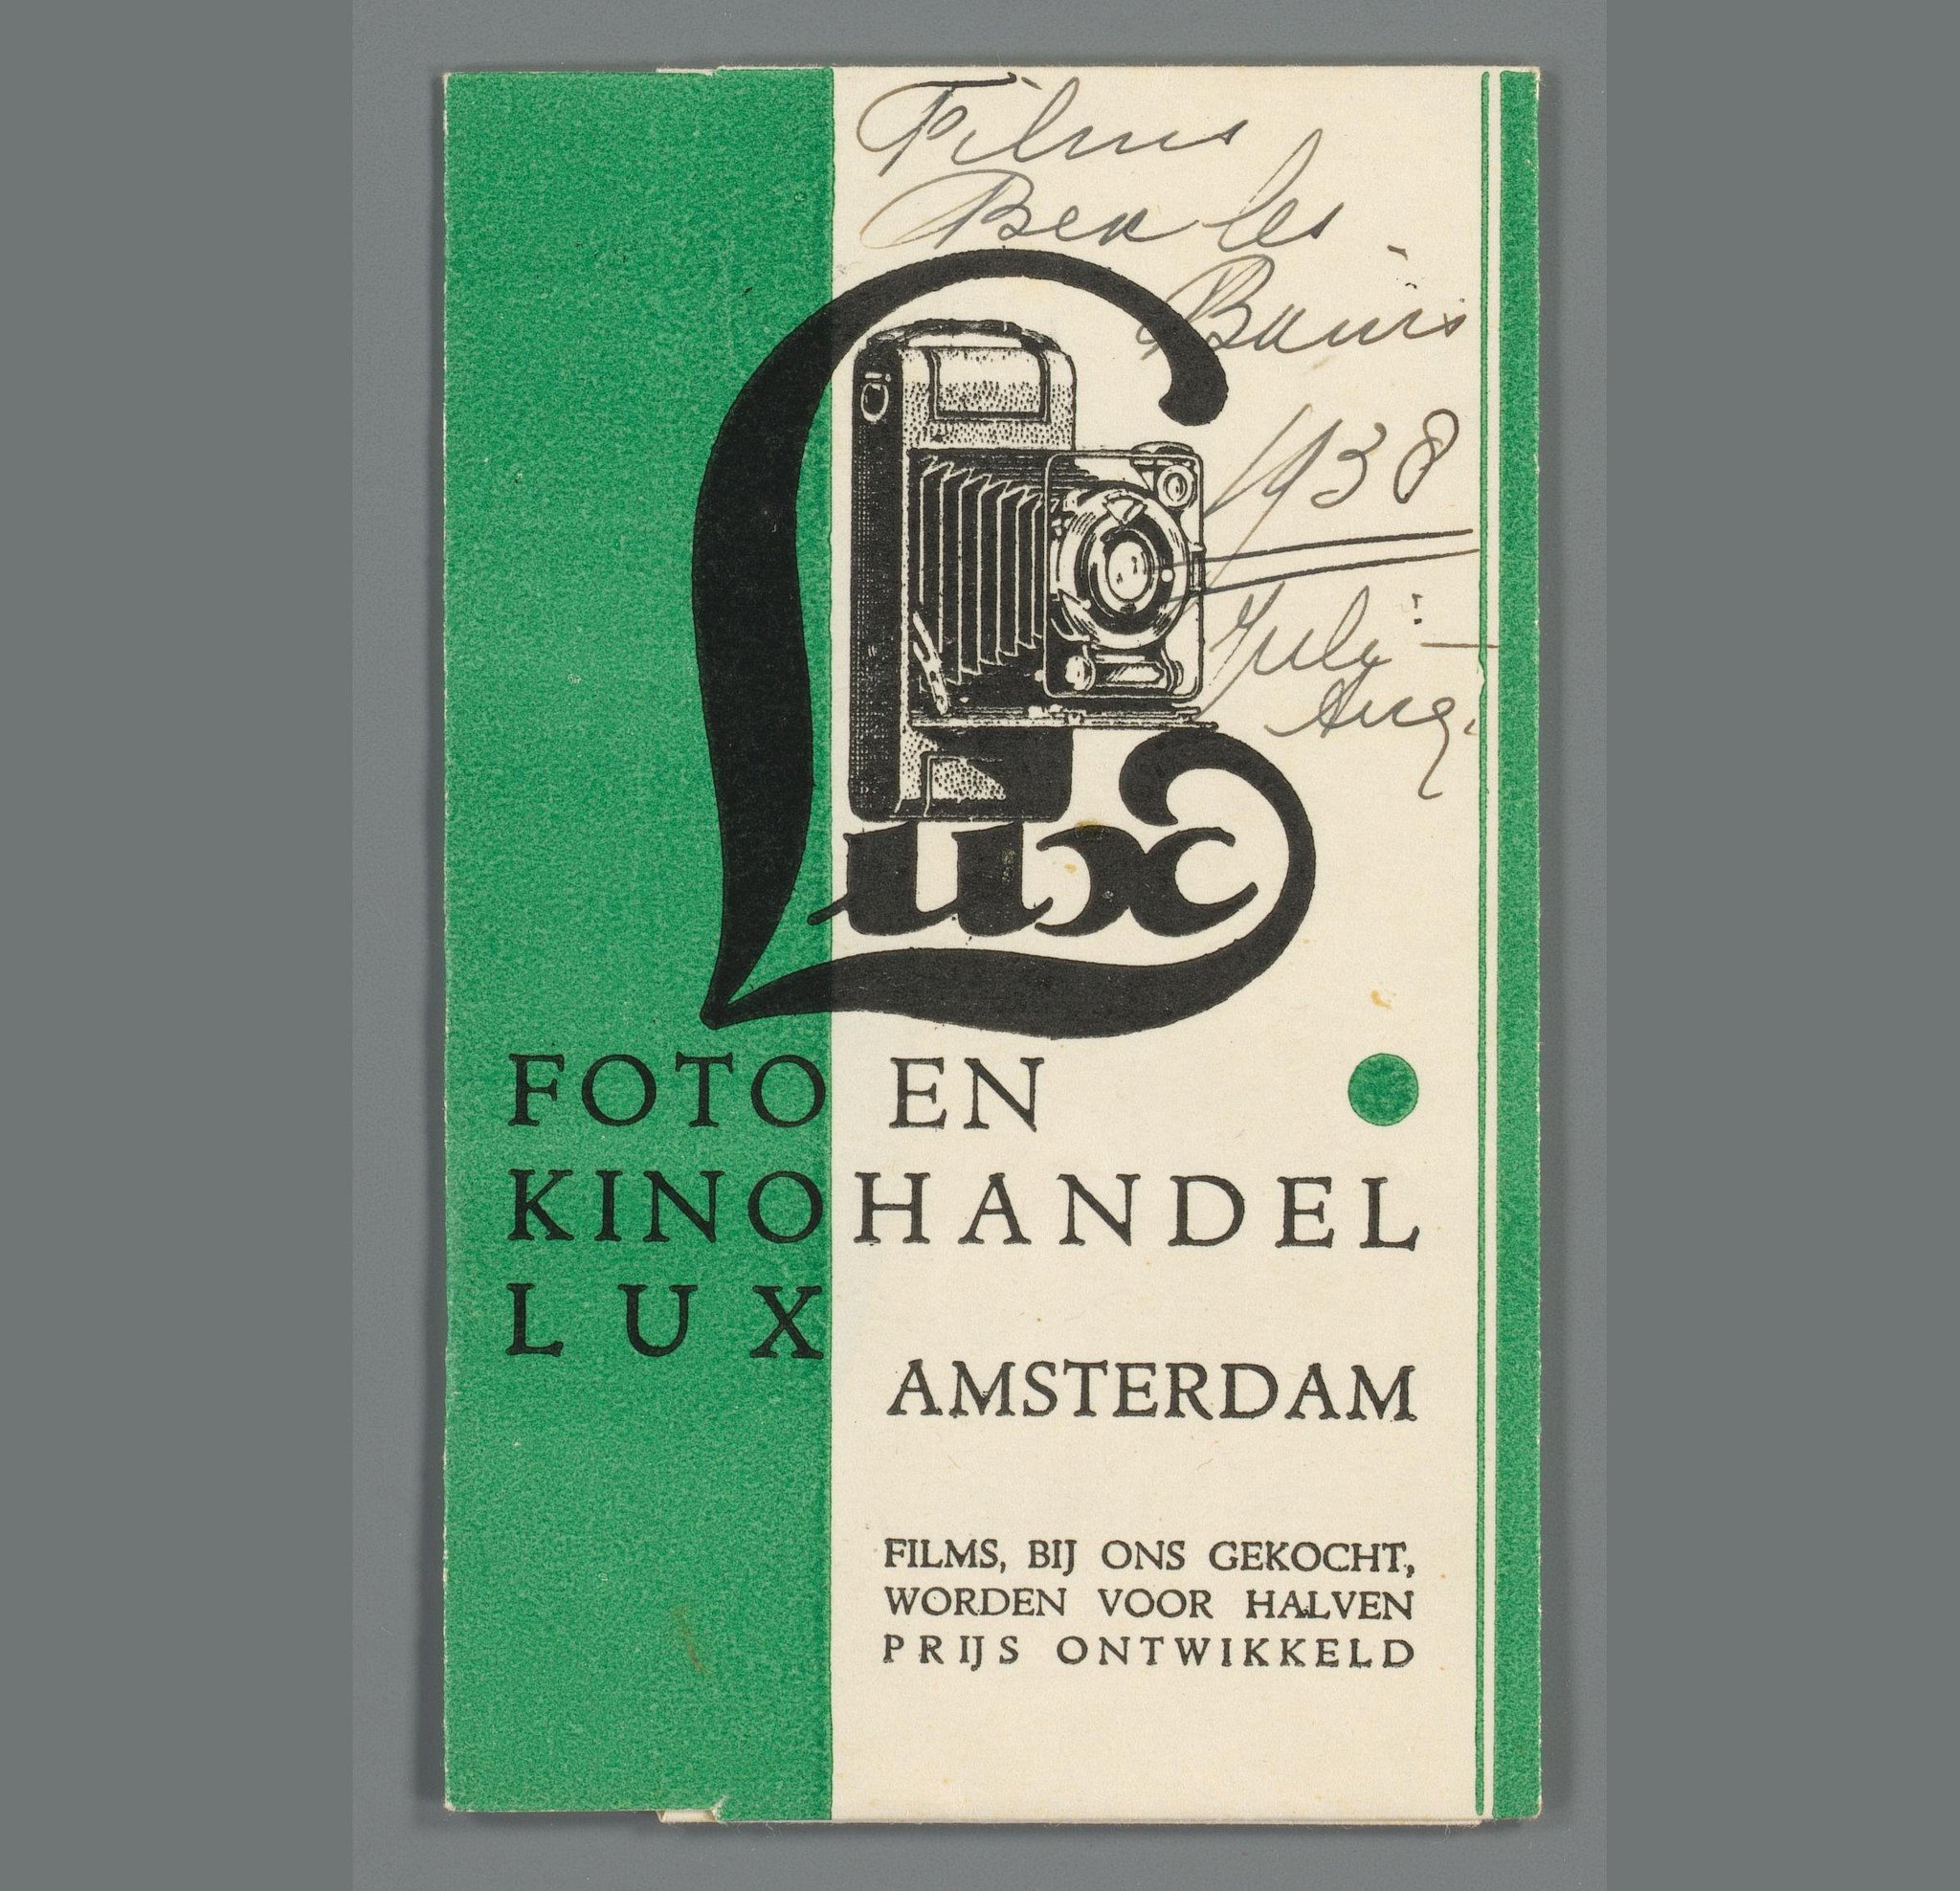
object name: photomap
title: Foto en kinohandel Lux Amsterdam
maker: Anonymous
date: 1938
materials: paper, film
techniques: gelatin silver negative, letterpress printing, printing block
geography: amsterdam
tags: camera ~ photography, mother and child(ren), woman and child(ren) (family group)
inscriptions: inscription: ‘Films/ Ben les/ Bains/ 1938/ Juli-/ Aug.’